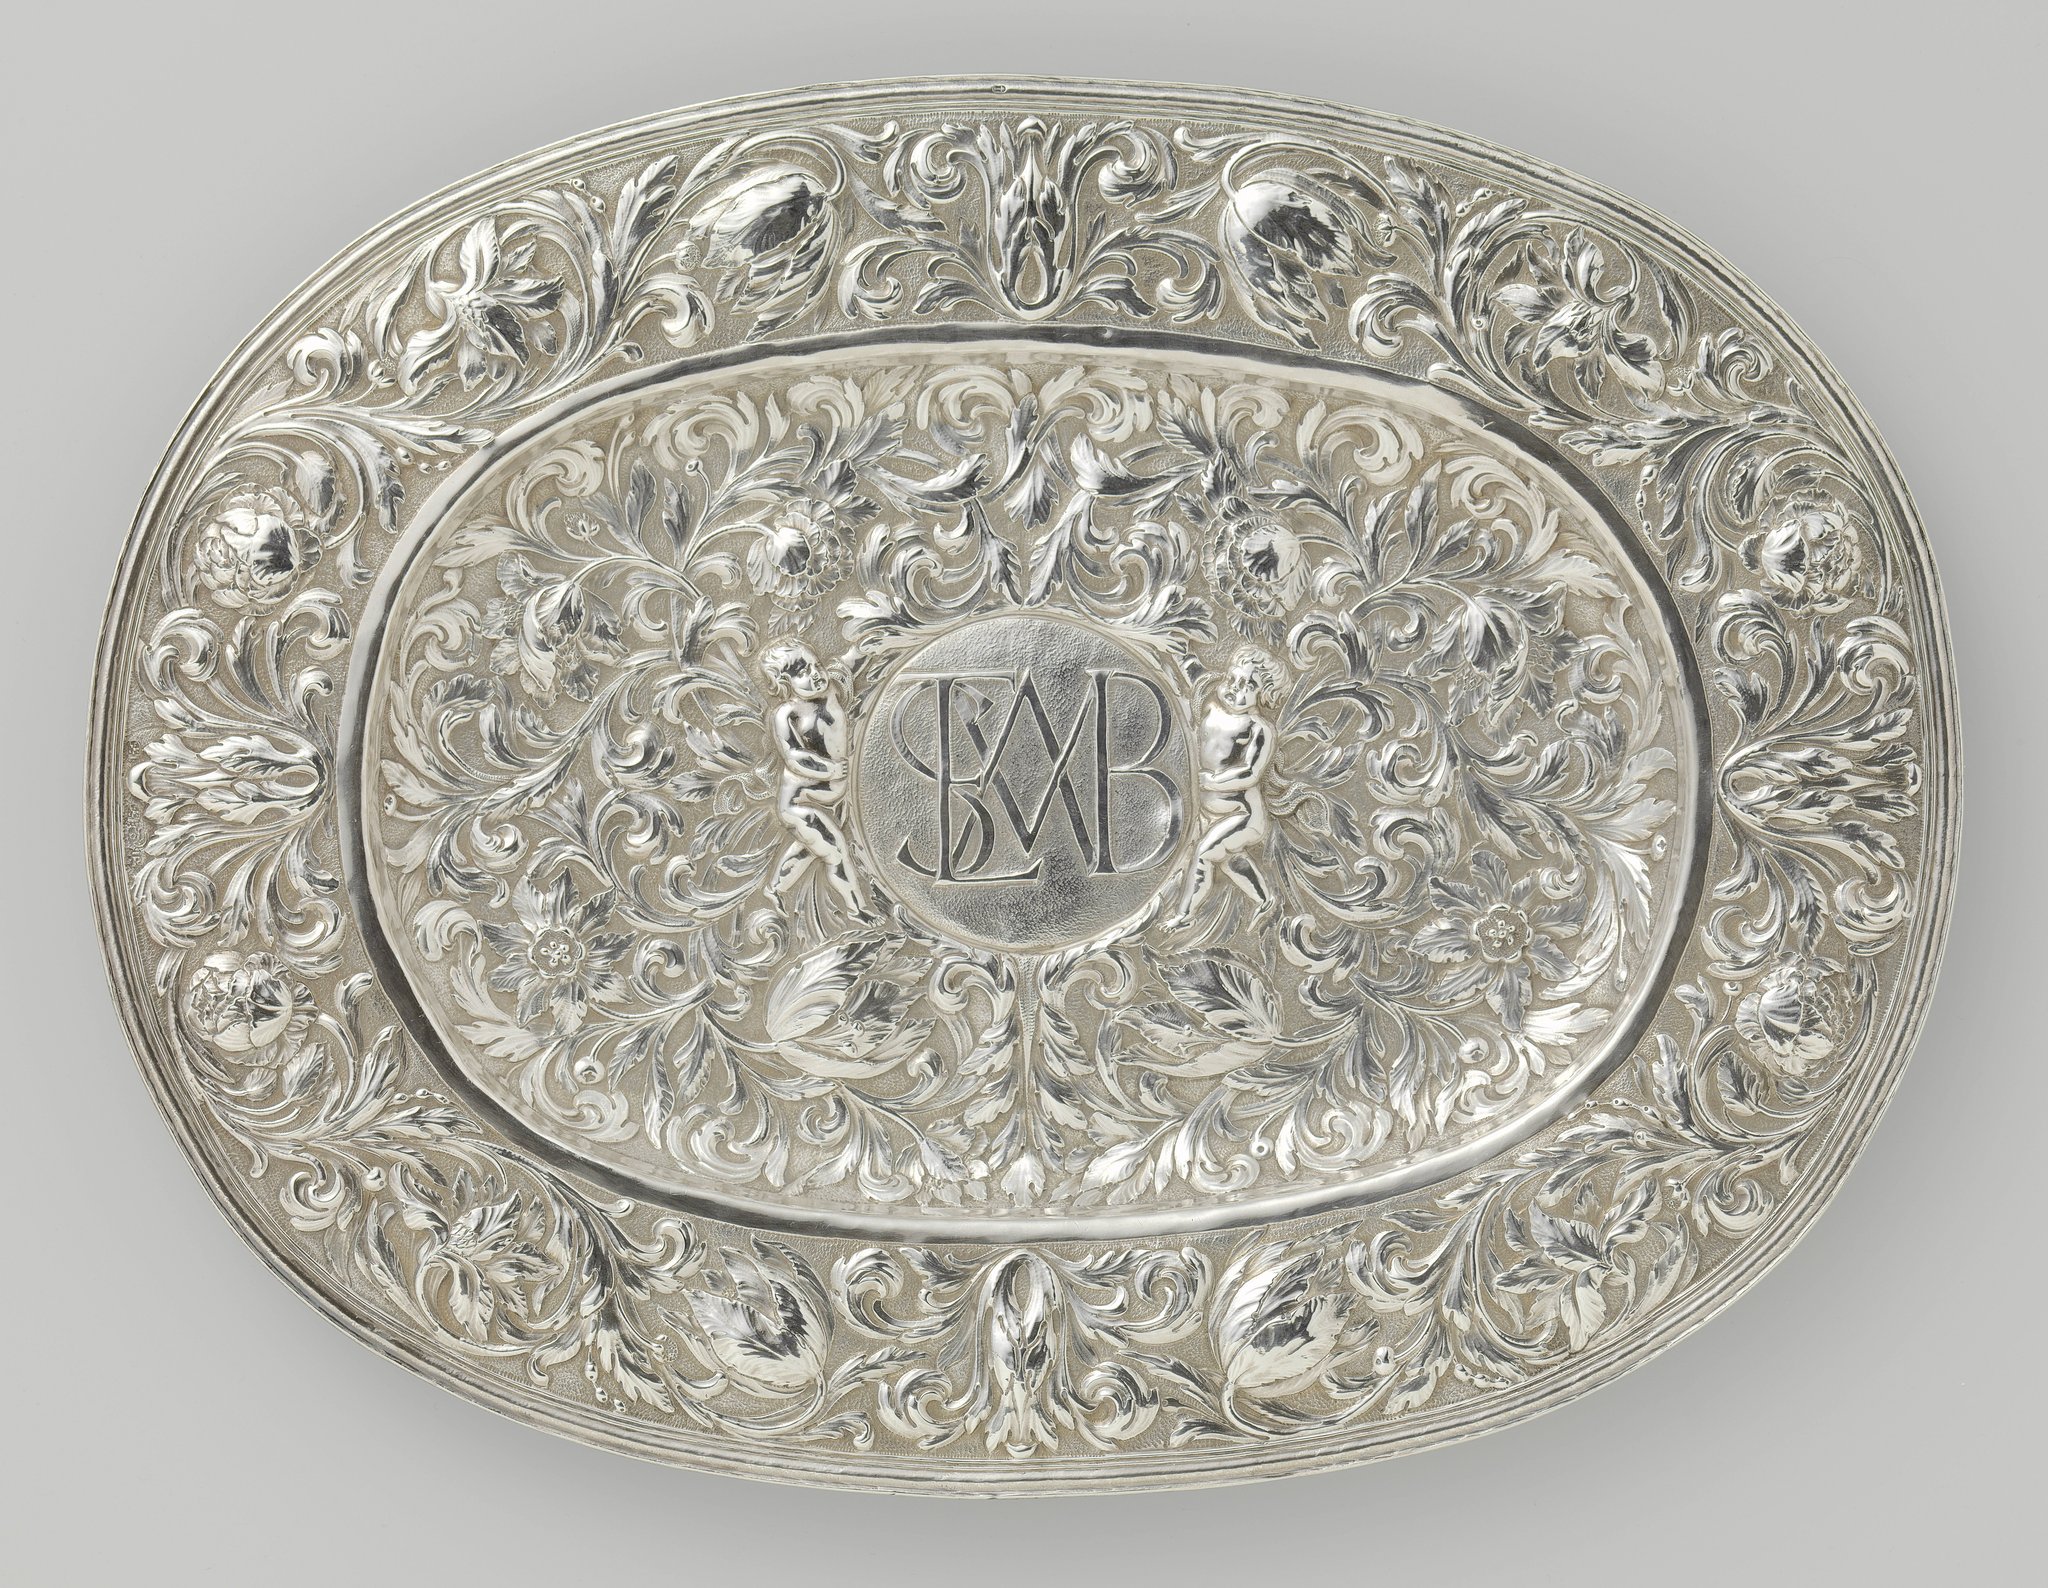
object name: washbowl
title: Lampetschaal, ovaal en geheel gedreven met bloemranken, met in het midden van de rand een medaillon met monogram, bestaande uit de letters SLMVB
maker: jonas gutsche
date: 1670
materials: silver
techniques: repoussé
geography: the hague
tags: flowers ~ ornament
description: Ewer and basin, silver, The Hague, 1669, by Jonas Gutsche.